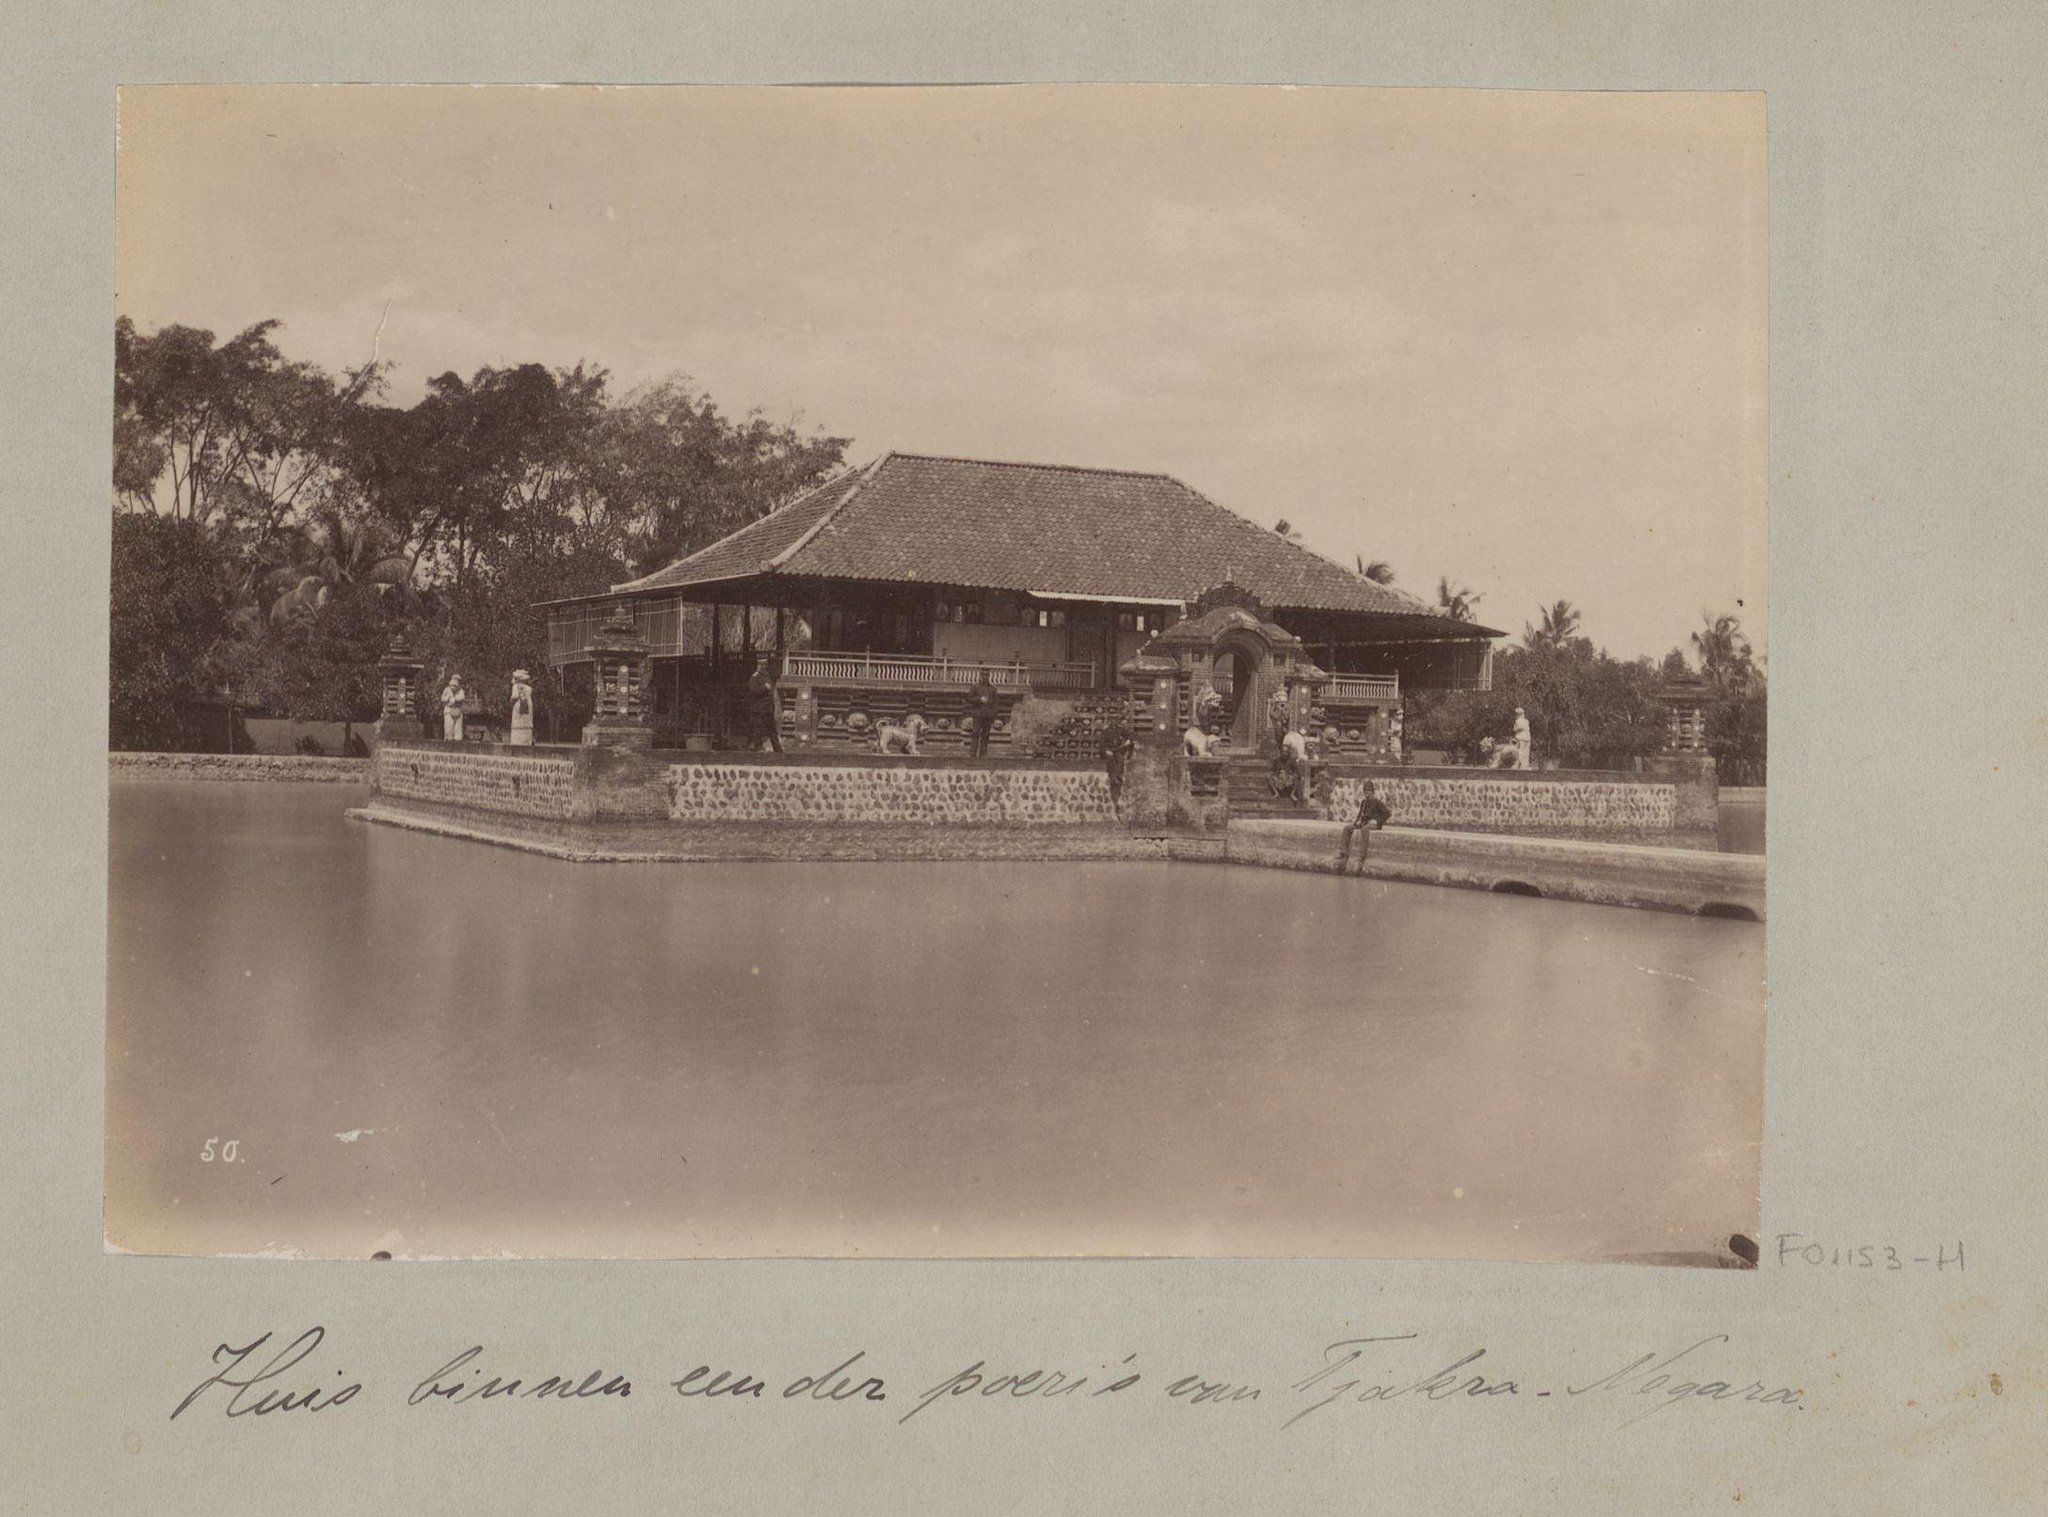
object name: photograph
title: Huis binnen een der poeri van Tjakra-Negara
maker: christiaan johan neeb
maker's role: arts, fotograaf, officier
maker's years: 1860-1925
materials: photographic support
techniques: albumen print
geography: lombok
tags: the soldier; the soldier's life, civic architecture; edifices; dwellings, dutch east indies, the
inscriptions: number: ‘50’